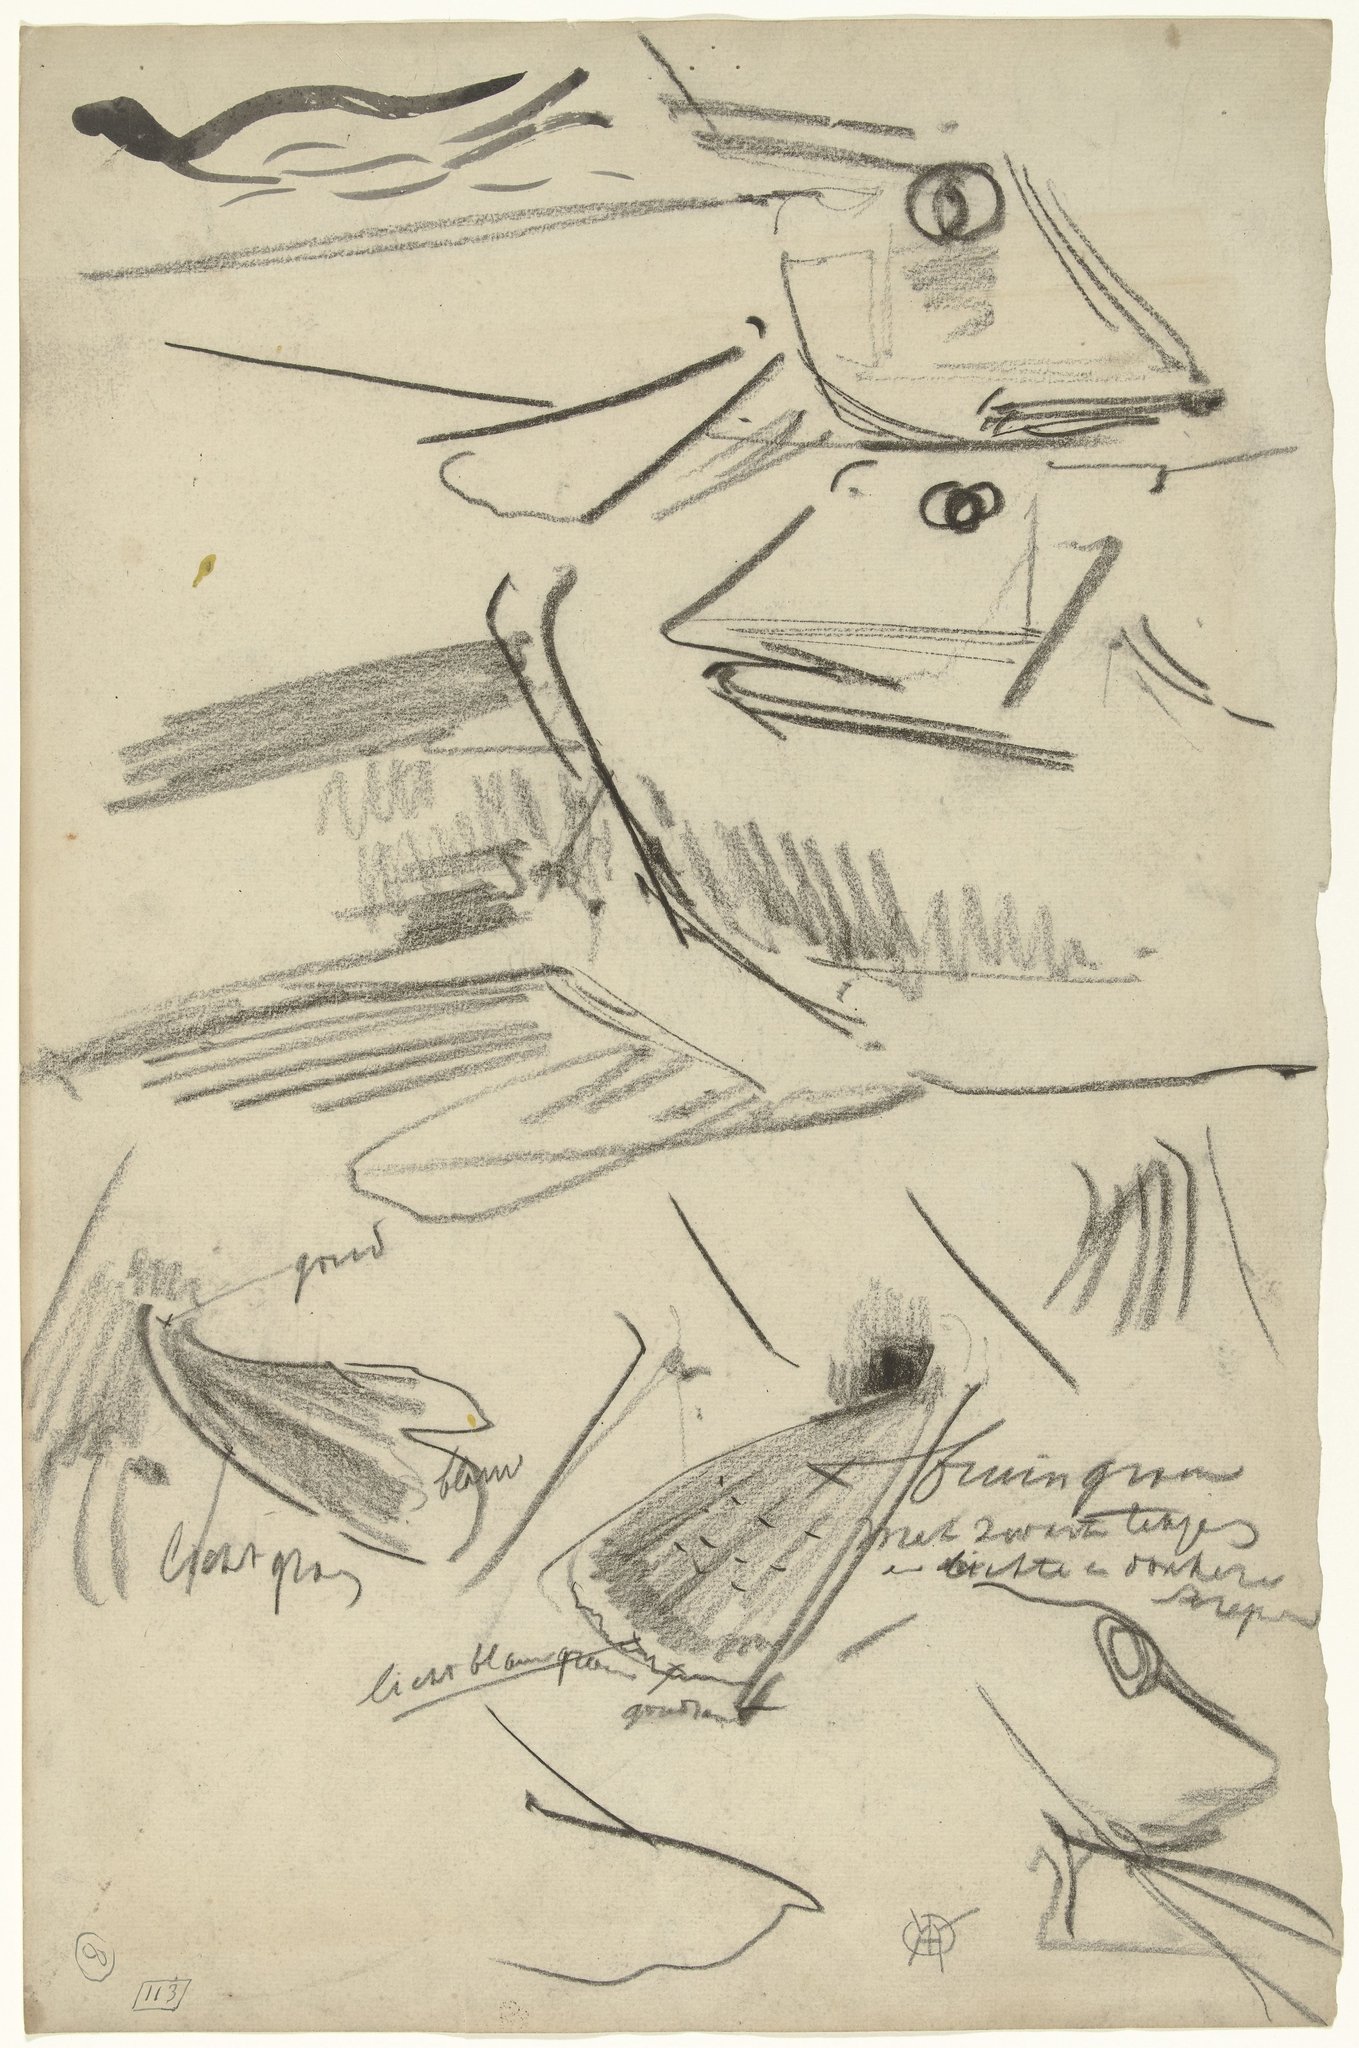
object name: drawing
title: Detailstudies van een poon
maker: gerrit willem dijsselhof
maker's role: designer, draughtsman, print maker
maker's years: 1866-1924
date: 1876-1924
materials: chalk, paper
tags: bony fishes: gurnard